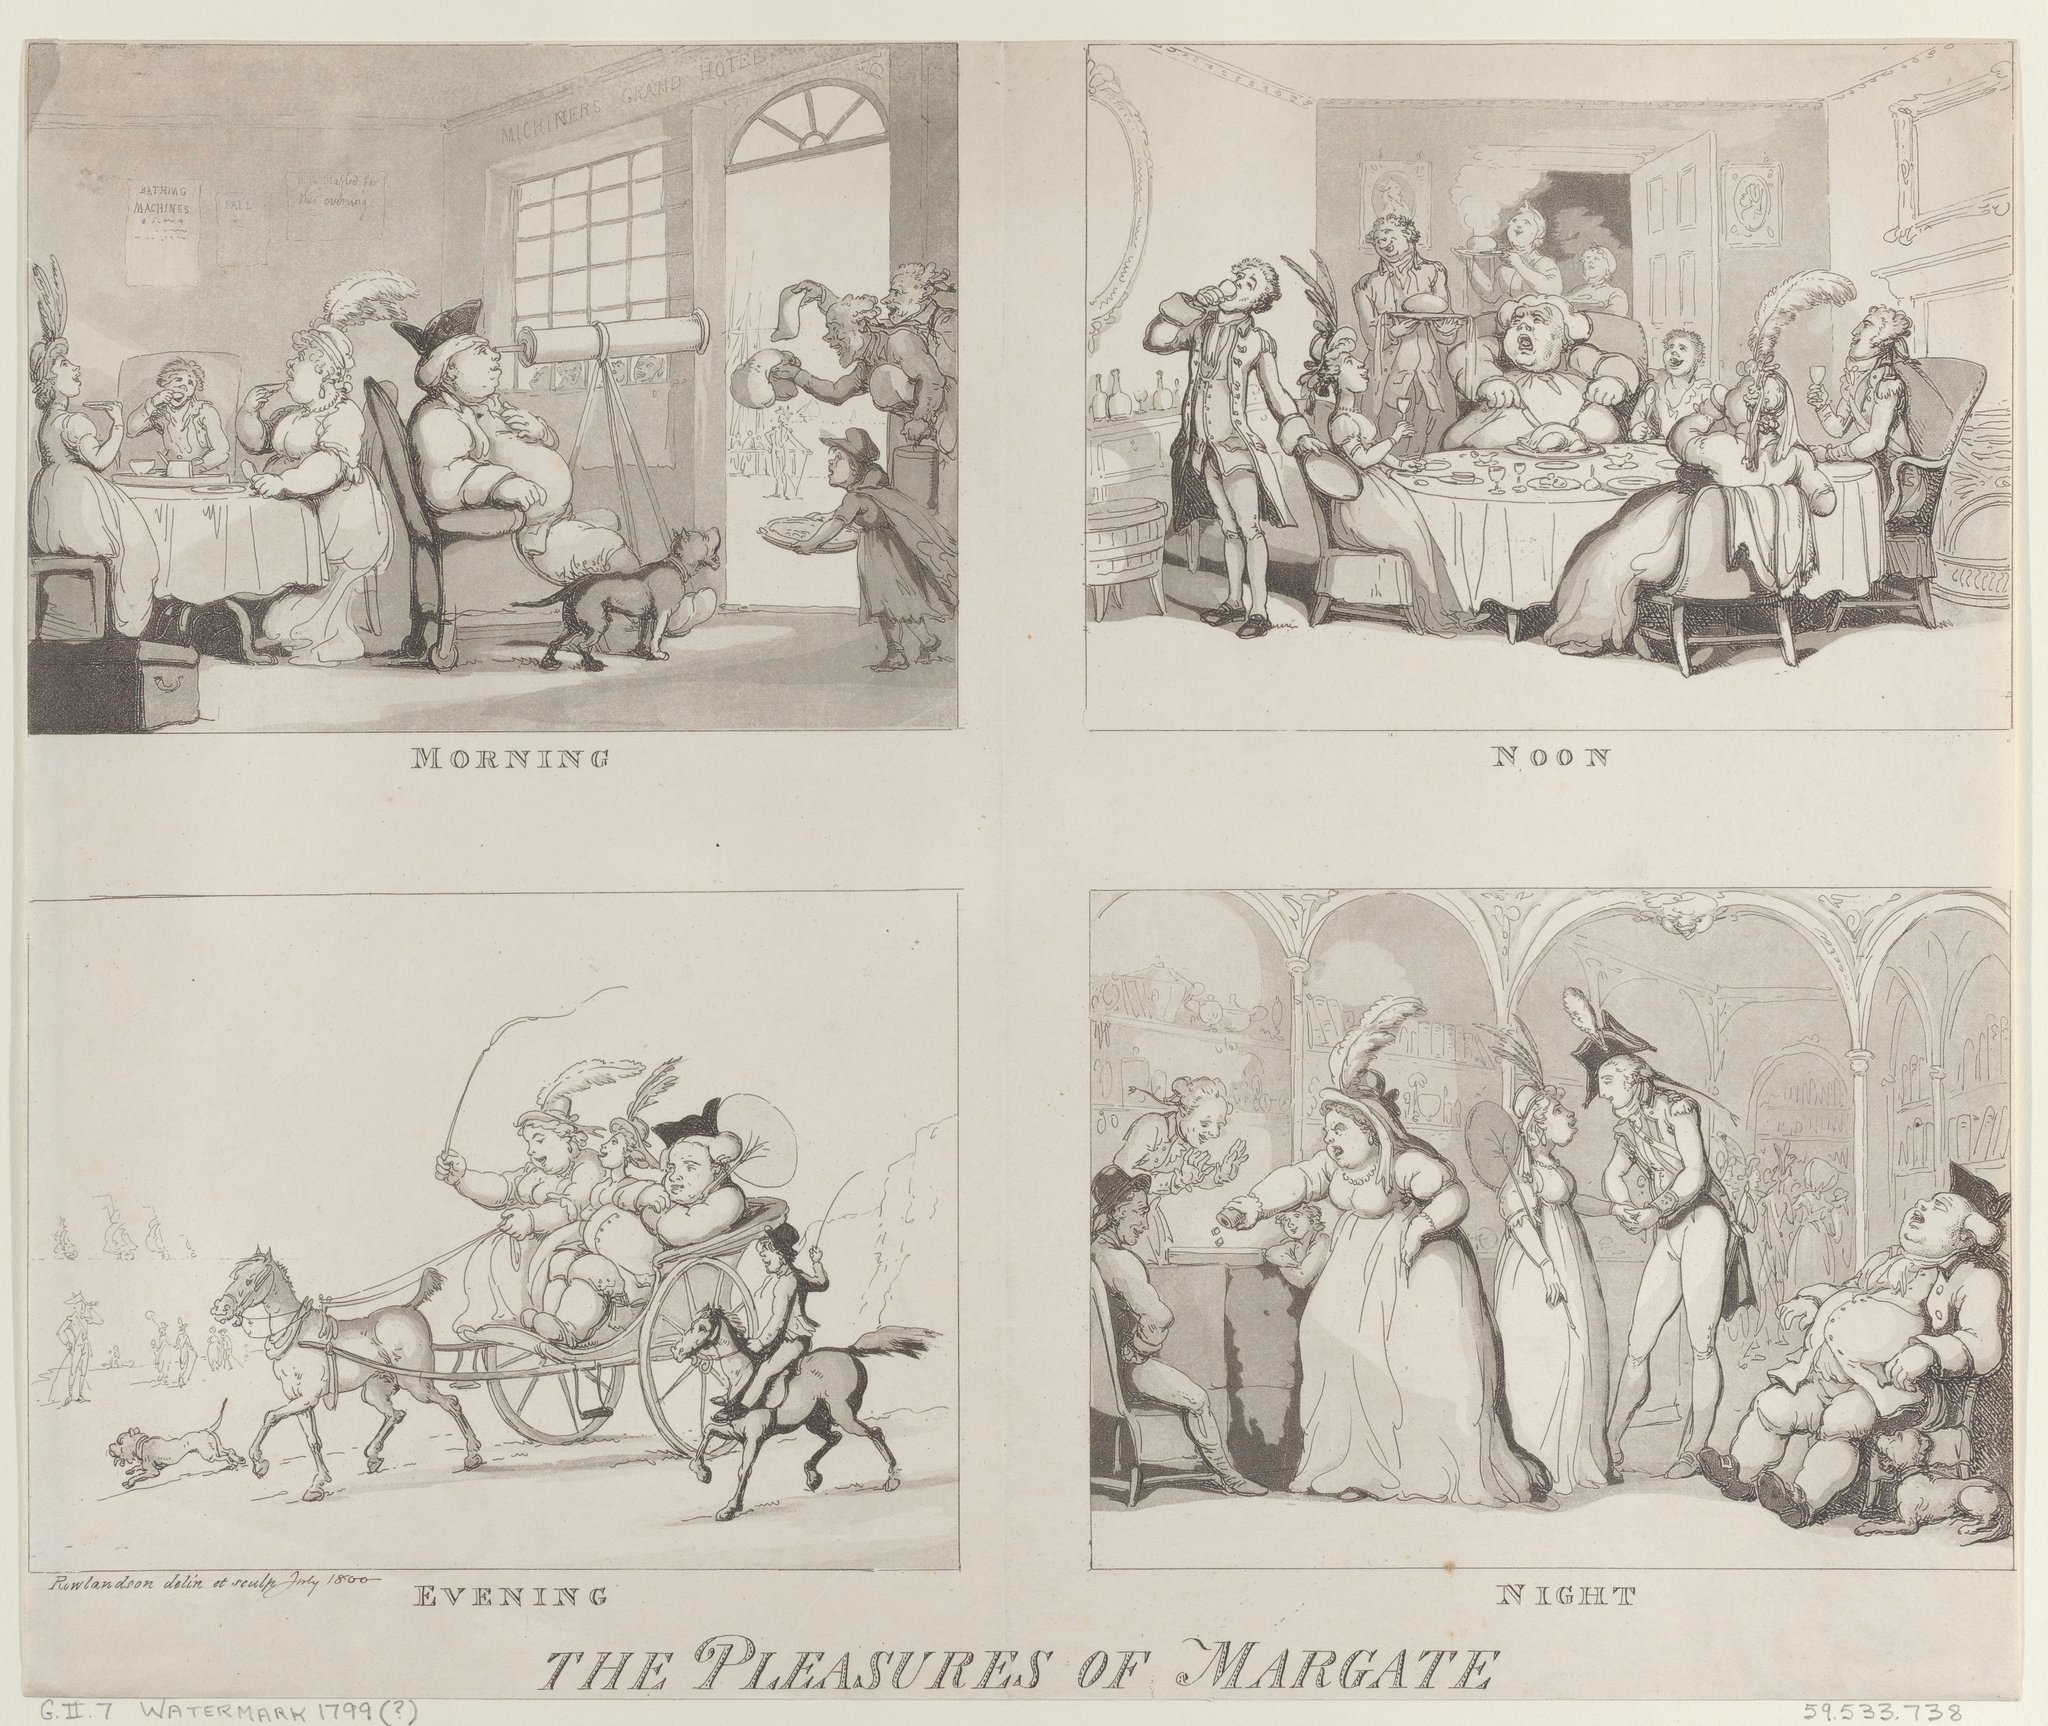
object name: print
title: The Pleasures of Margate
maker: thomas rowlandson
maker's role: artist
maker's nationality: british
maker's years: 1757-1827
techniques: aquatint, etching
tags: men,women,dogs,horses,dining,carriages